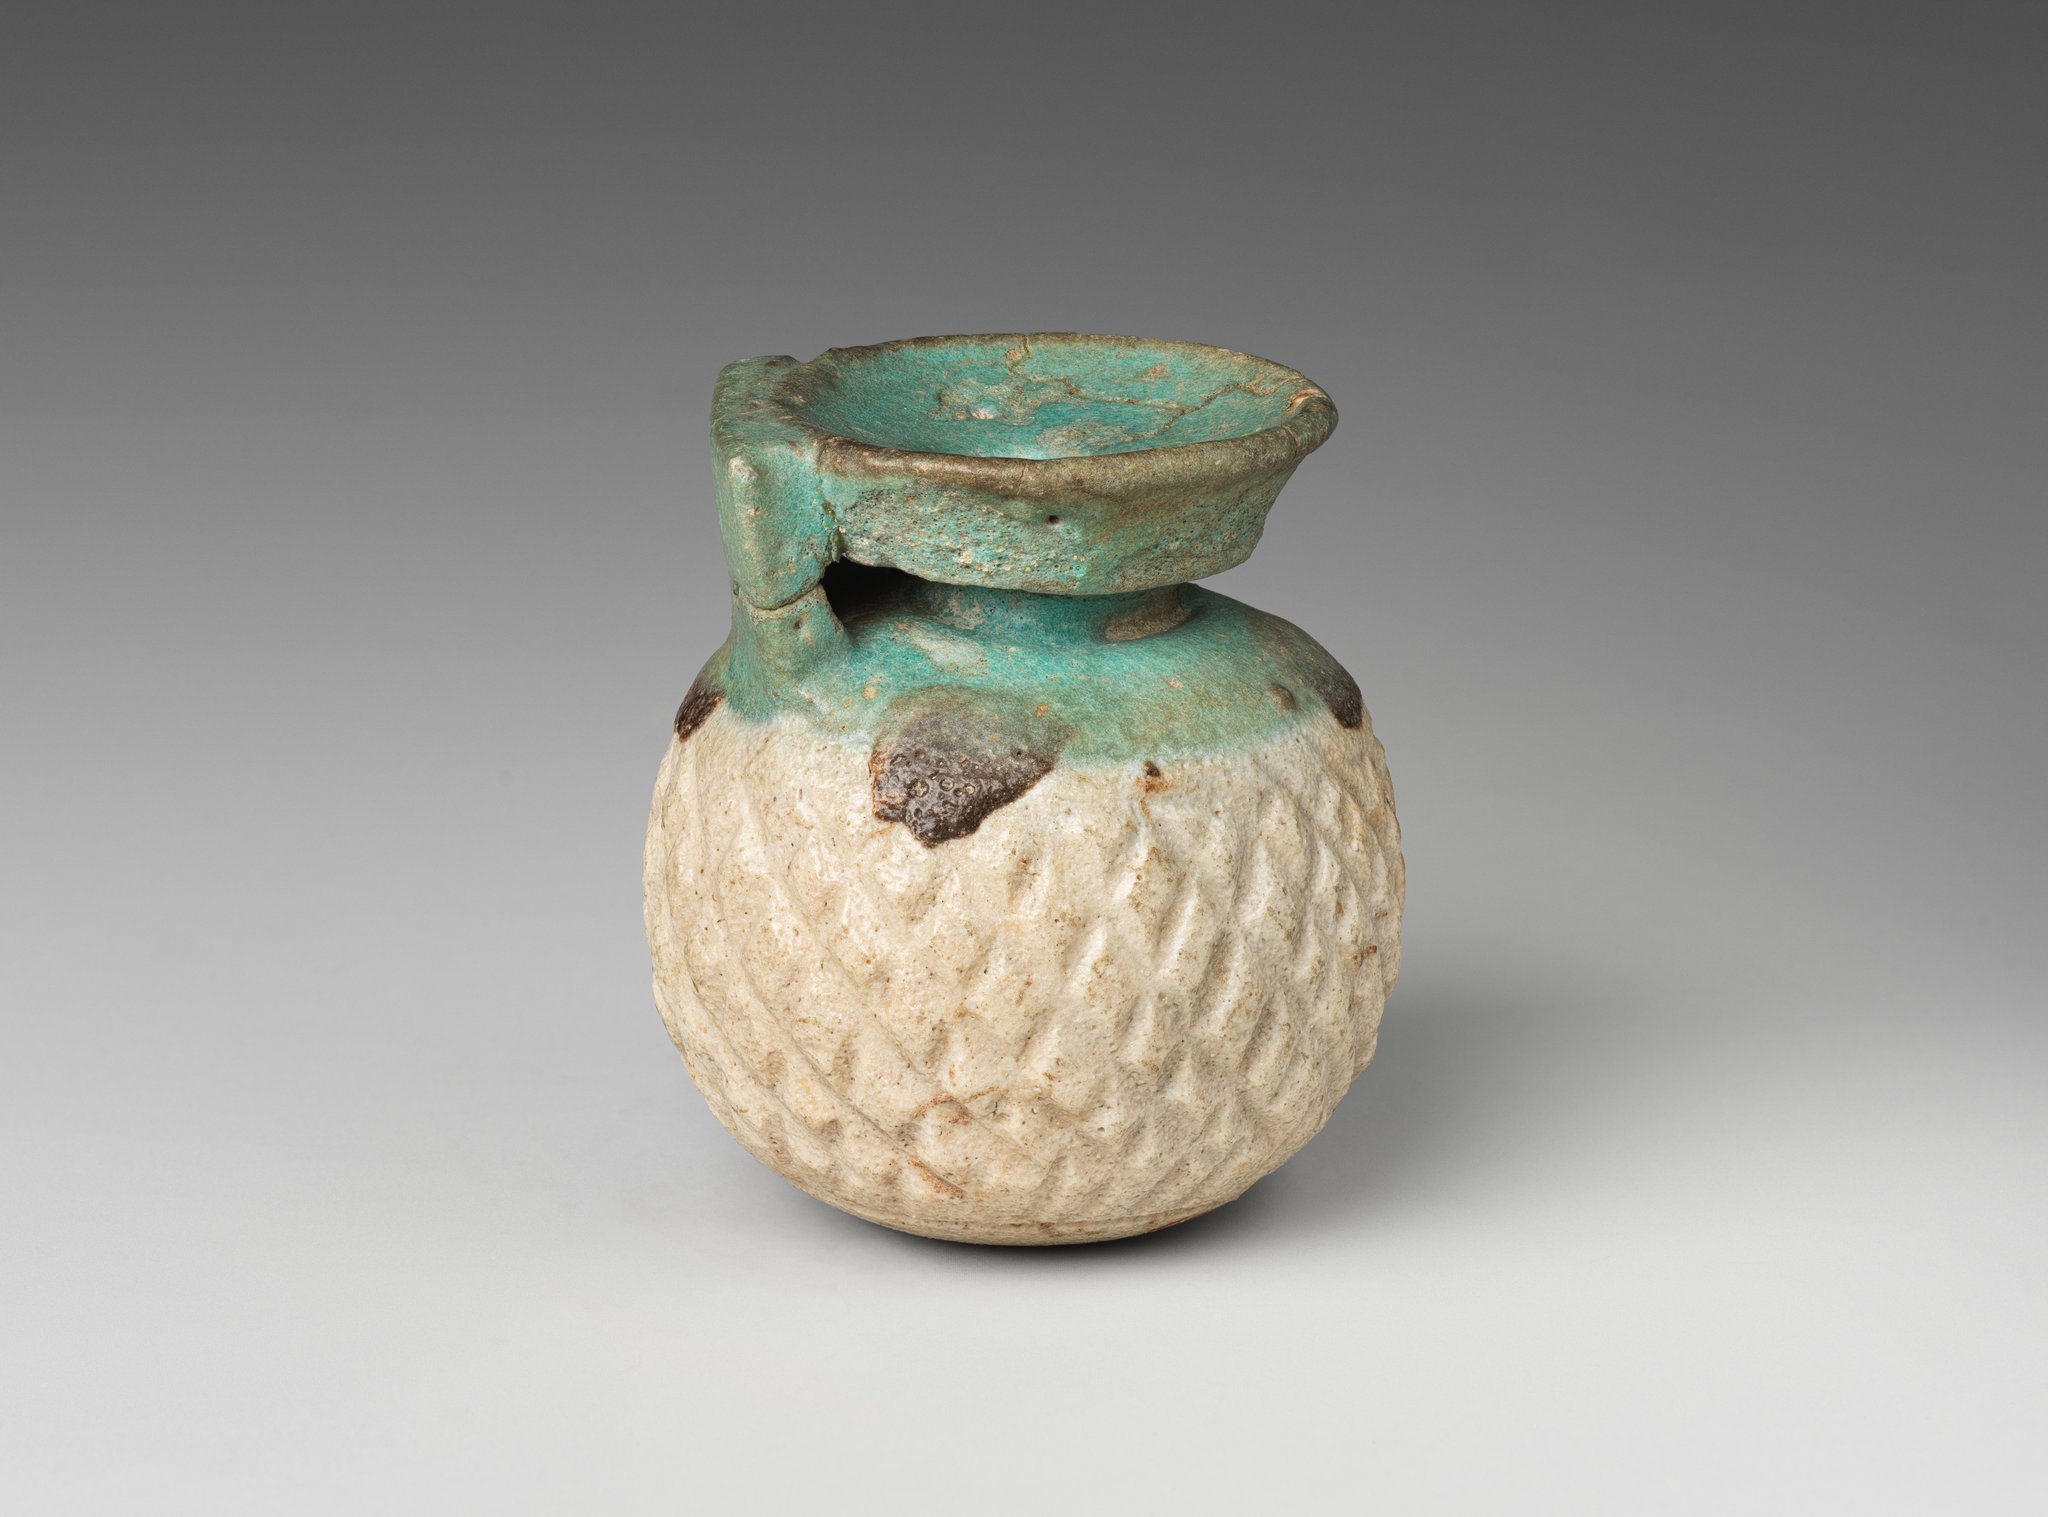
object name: jar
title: Aryballos (perfume jar)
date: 600-501 BCE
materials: faience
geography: egypt